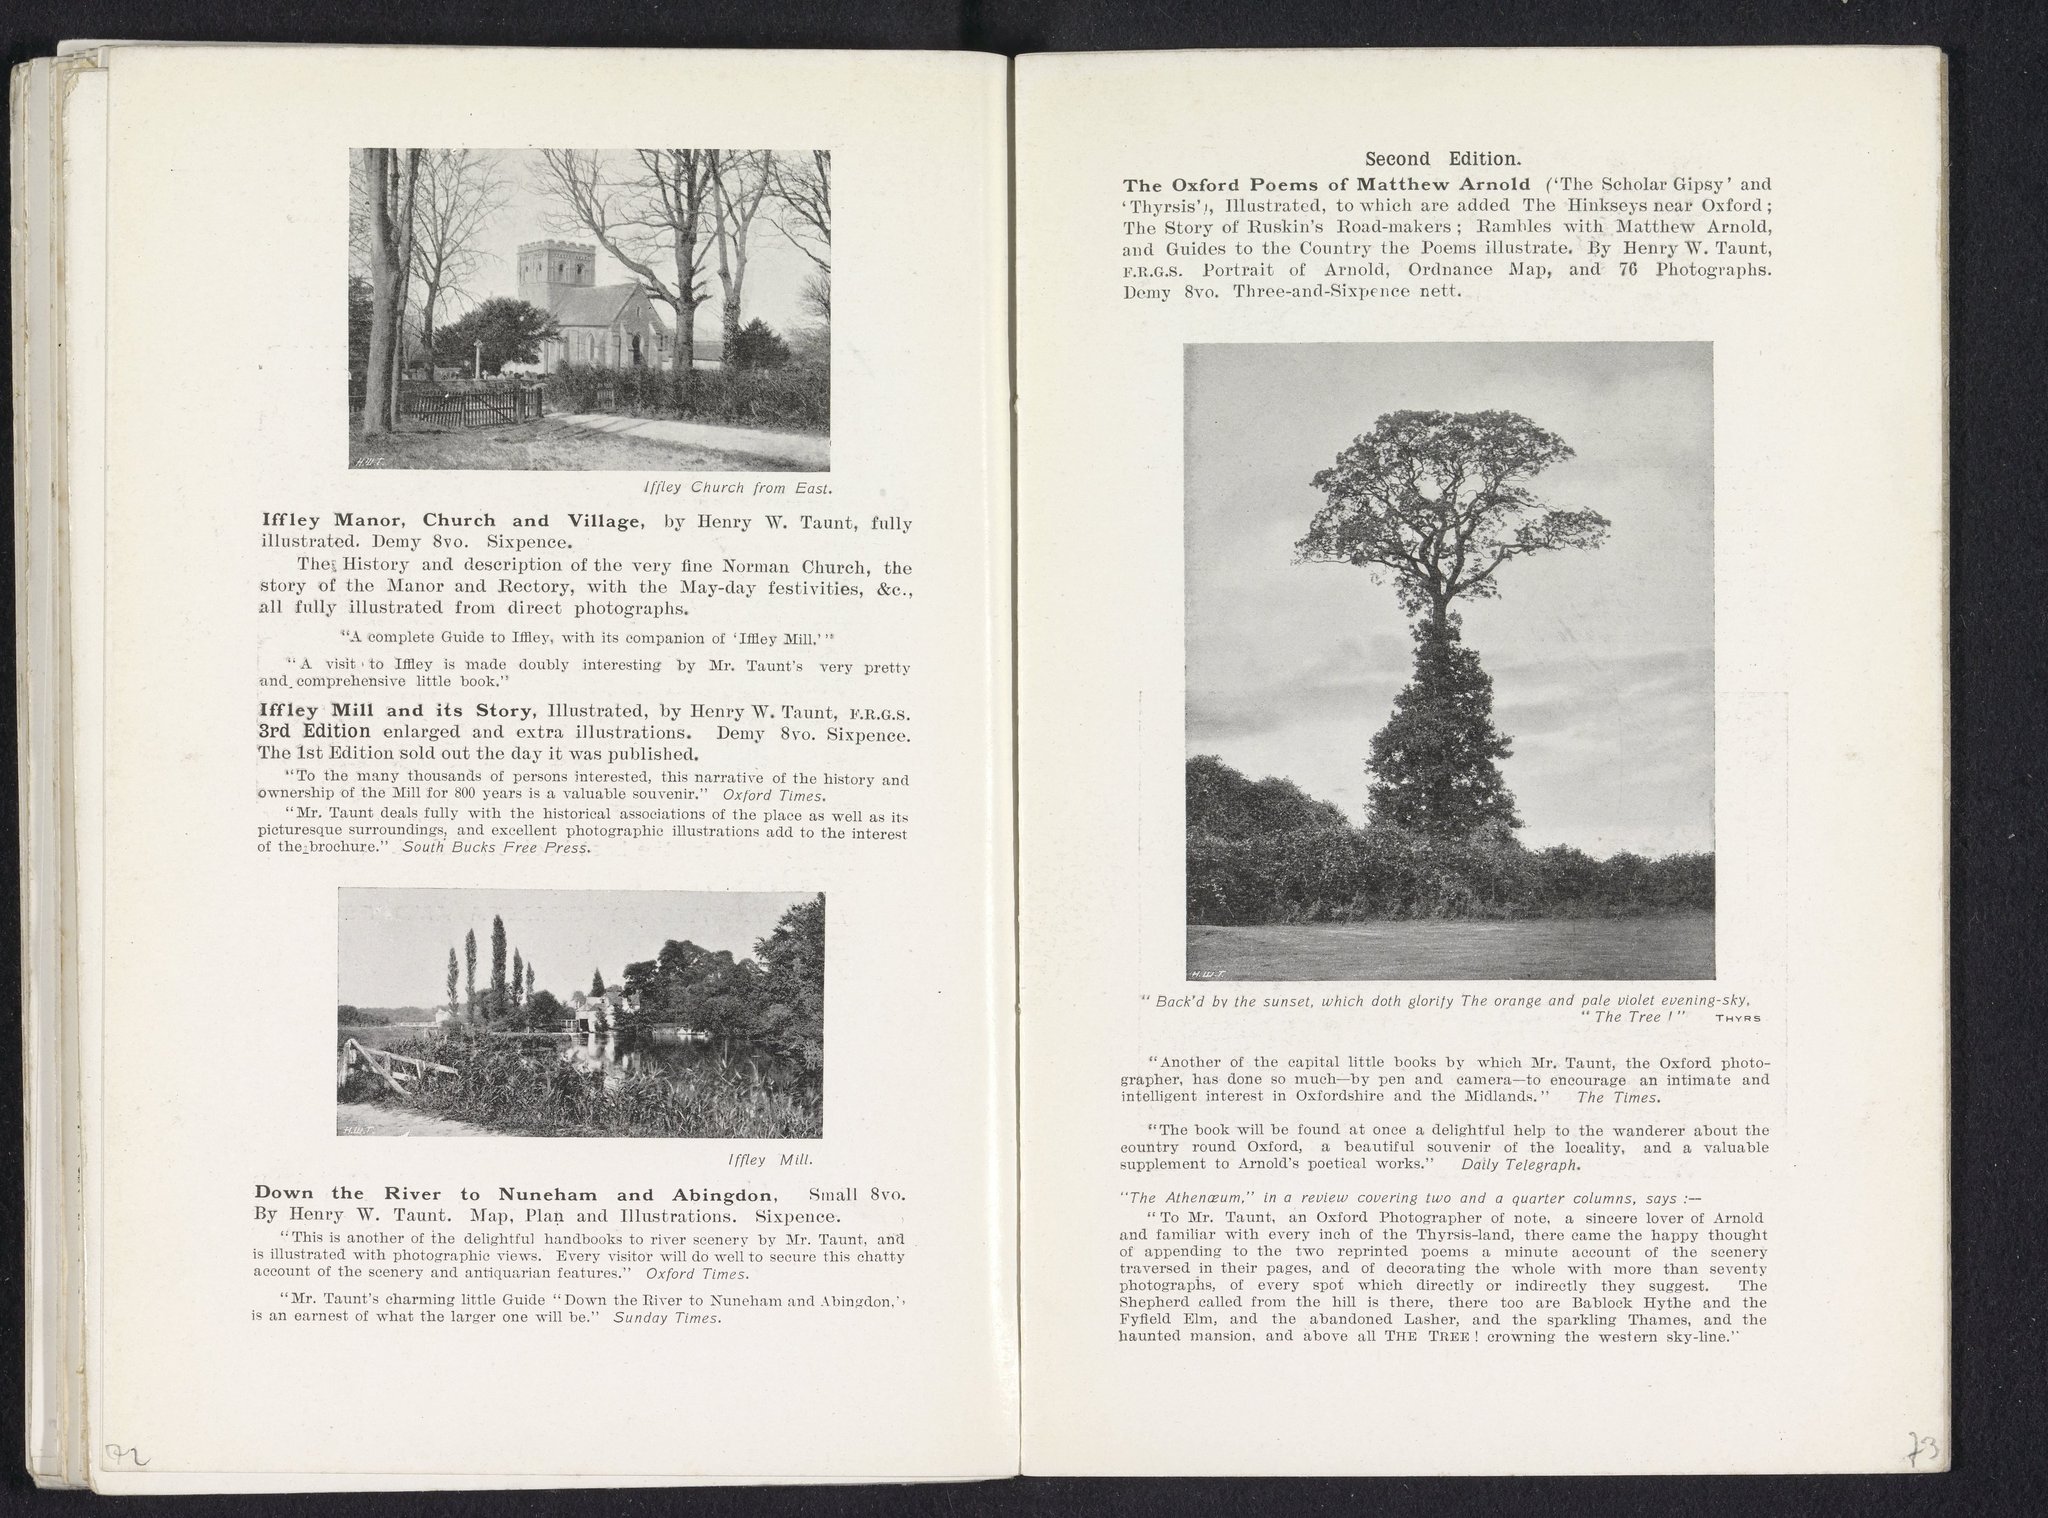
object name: page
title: Iffley Church from East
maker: henry w. taunt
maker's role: fotograaf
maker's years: 1842-1922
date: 1907-1912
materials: paper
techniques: autotype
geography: iffley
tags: church (exterior), watermill in landscape